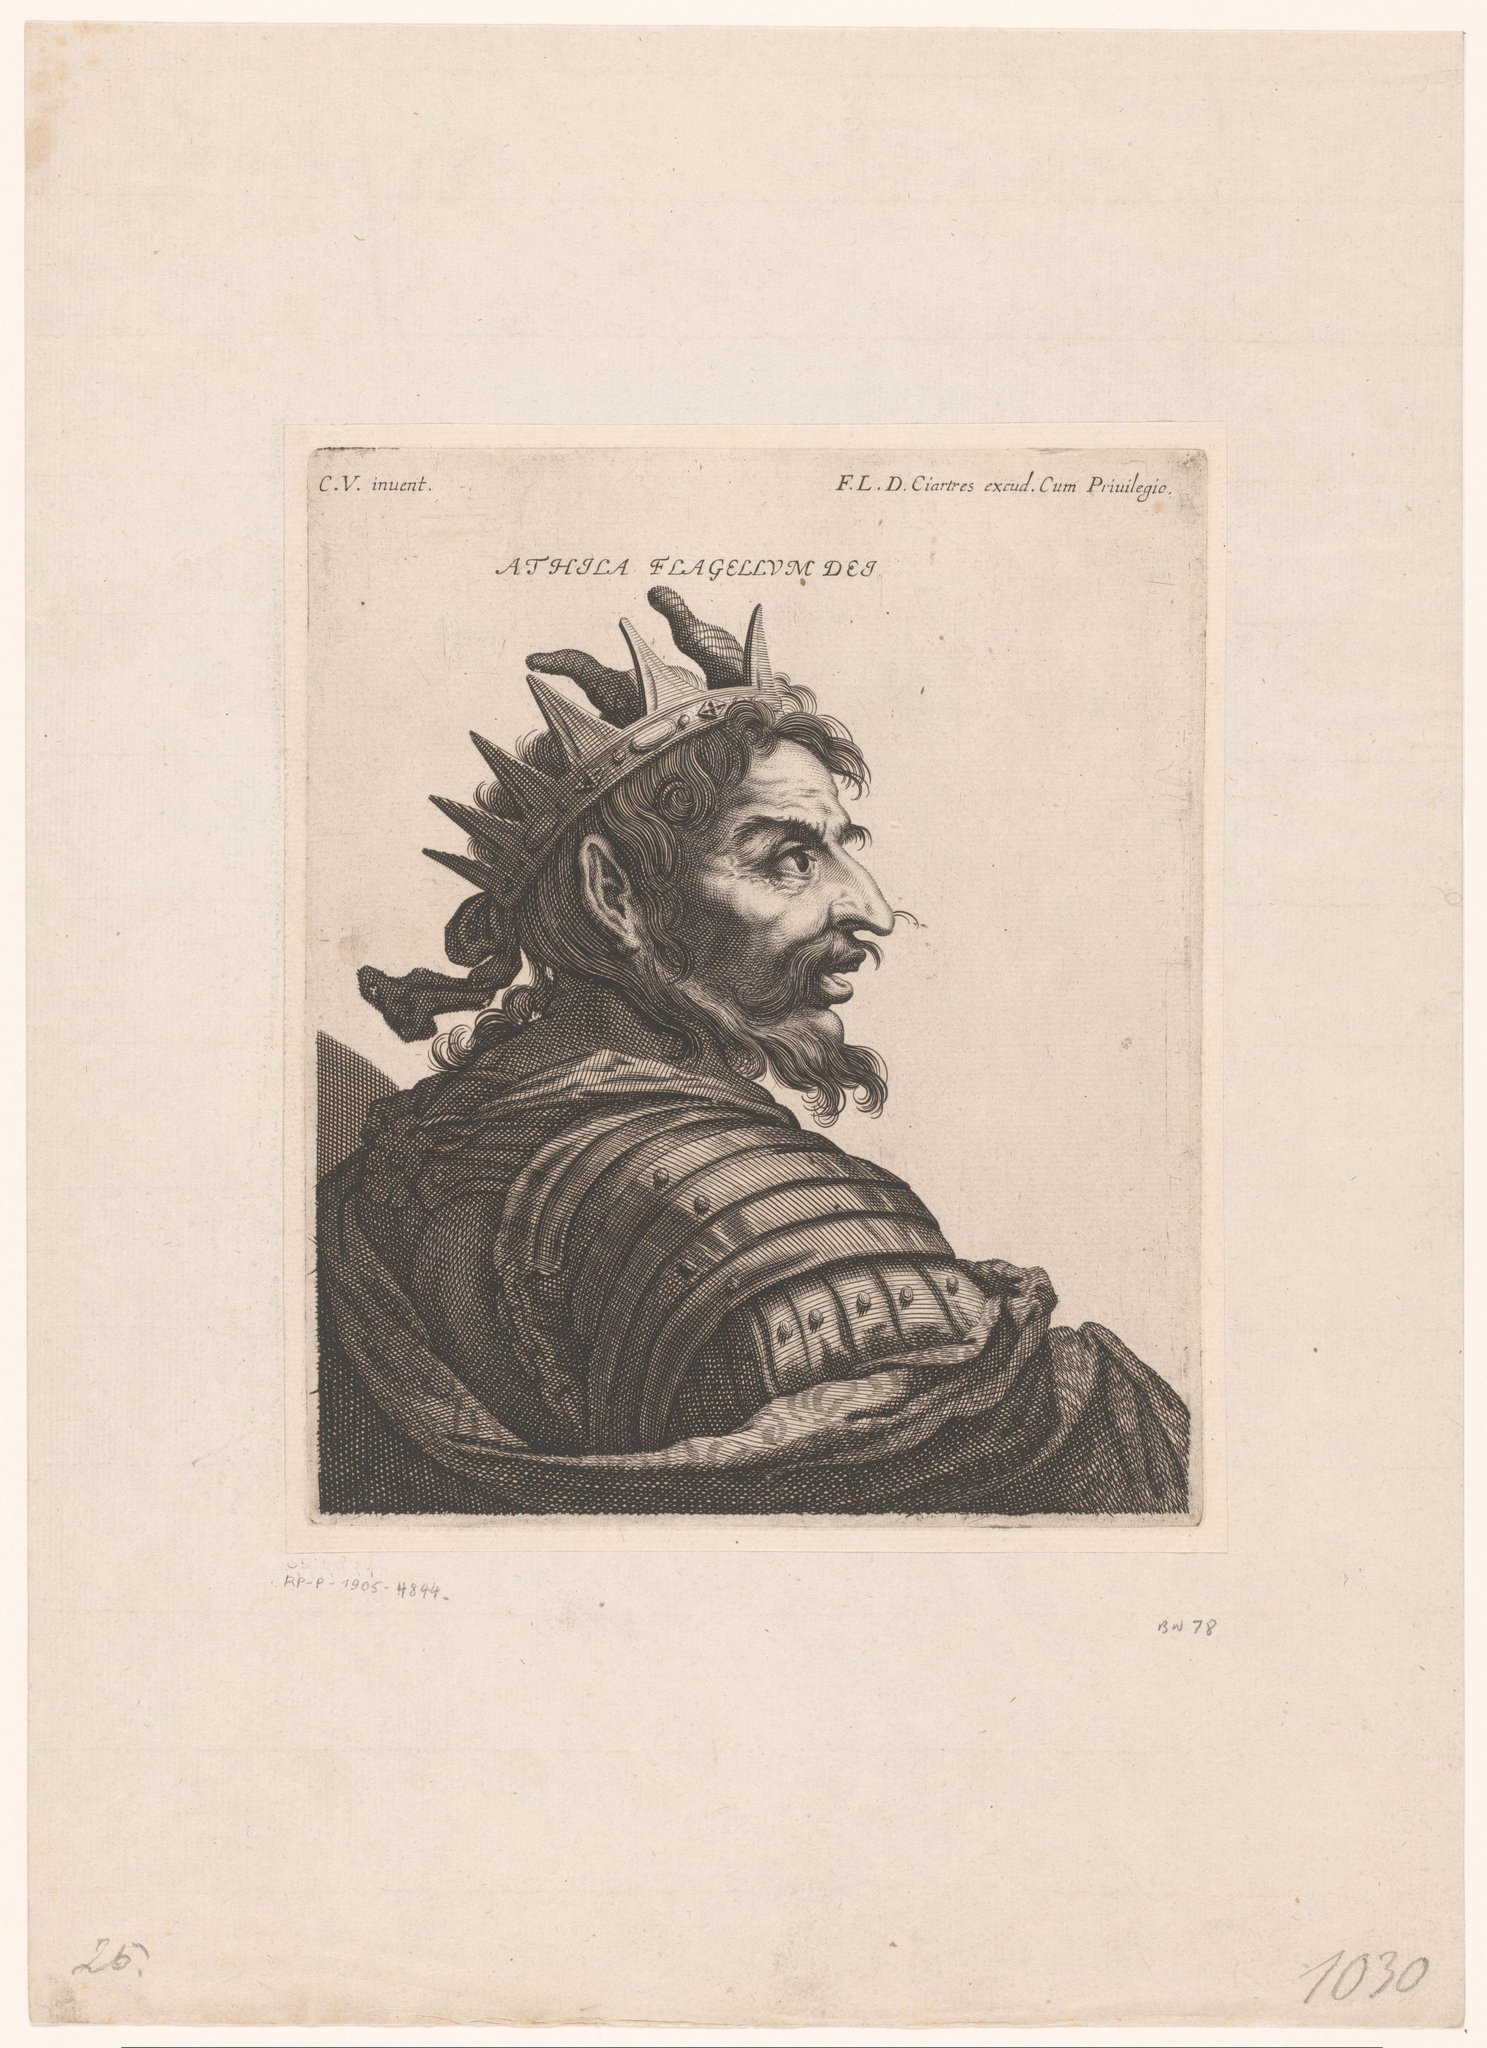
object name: print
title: Attila met hoorns en kroon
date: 1615-1647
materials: paper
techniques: engraving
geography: france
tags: historical persons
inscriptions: collector's mark: Lugt 2228